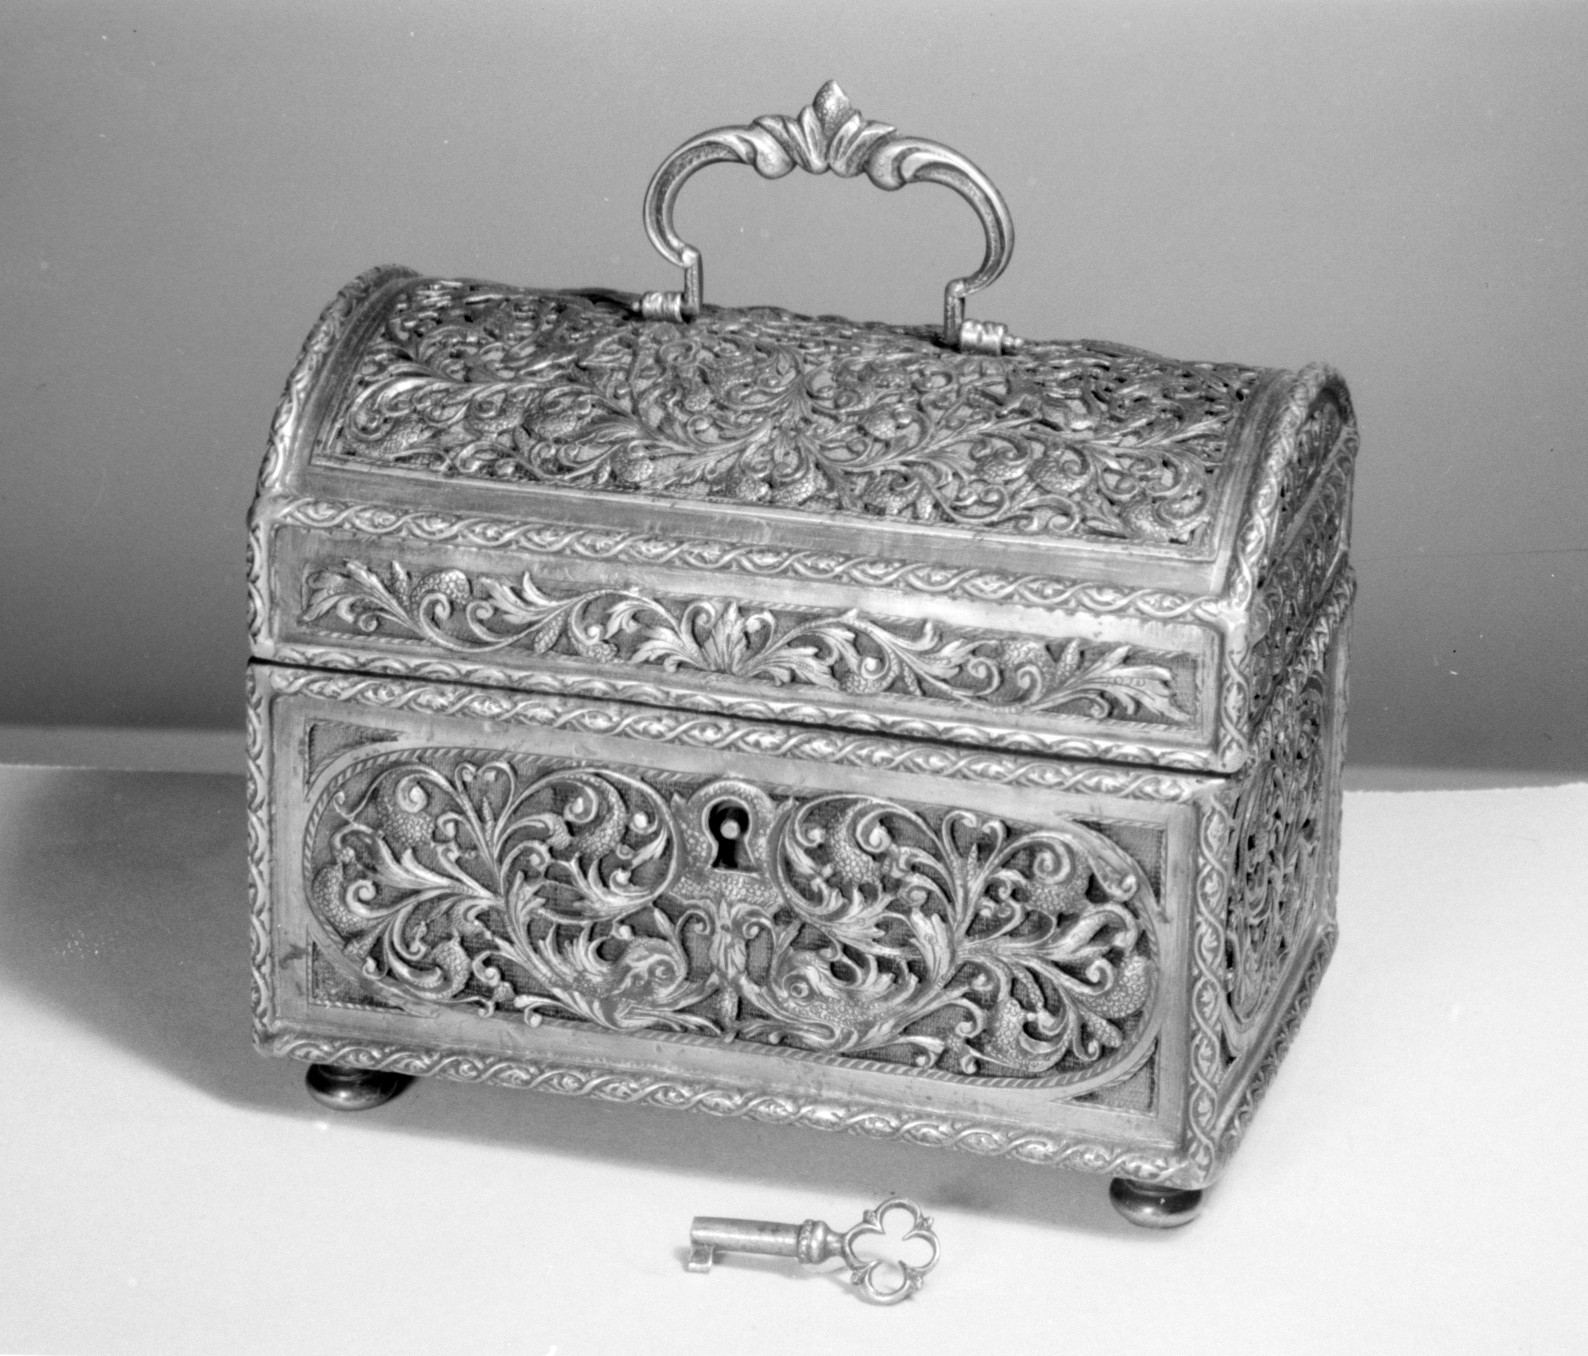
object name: casket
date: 1680-1700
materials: brass, linen, wood, panel, steel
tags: acanthus